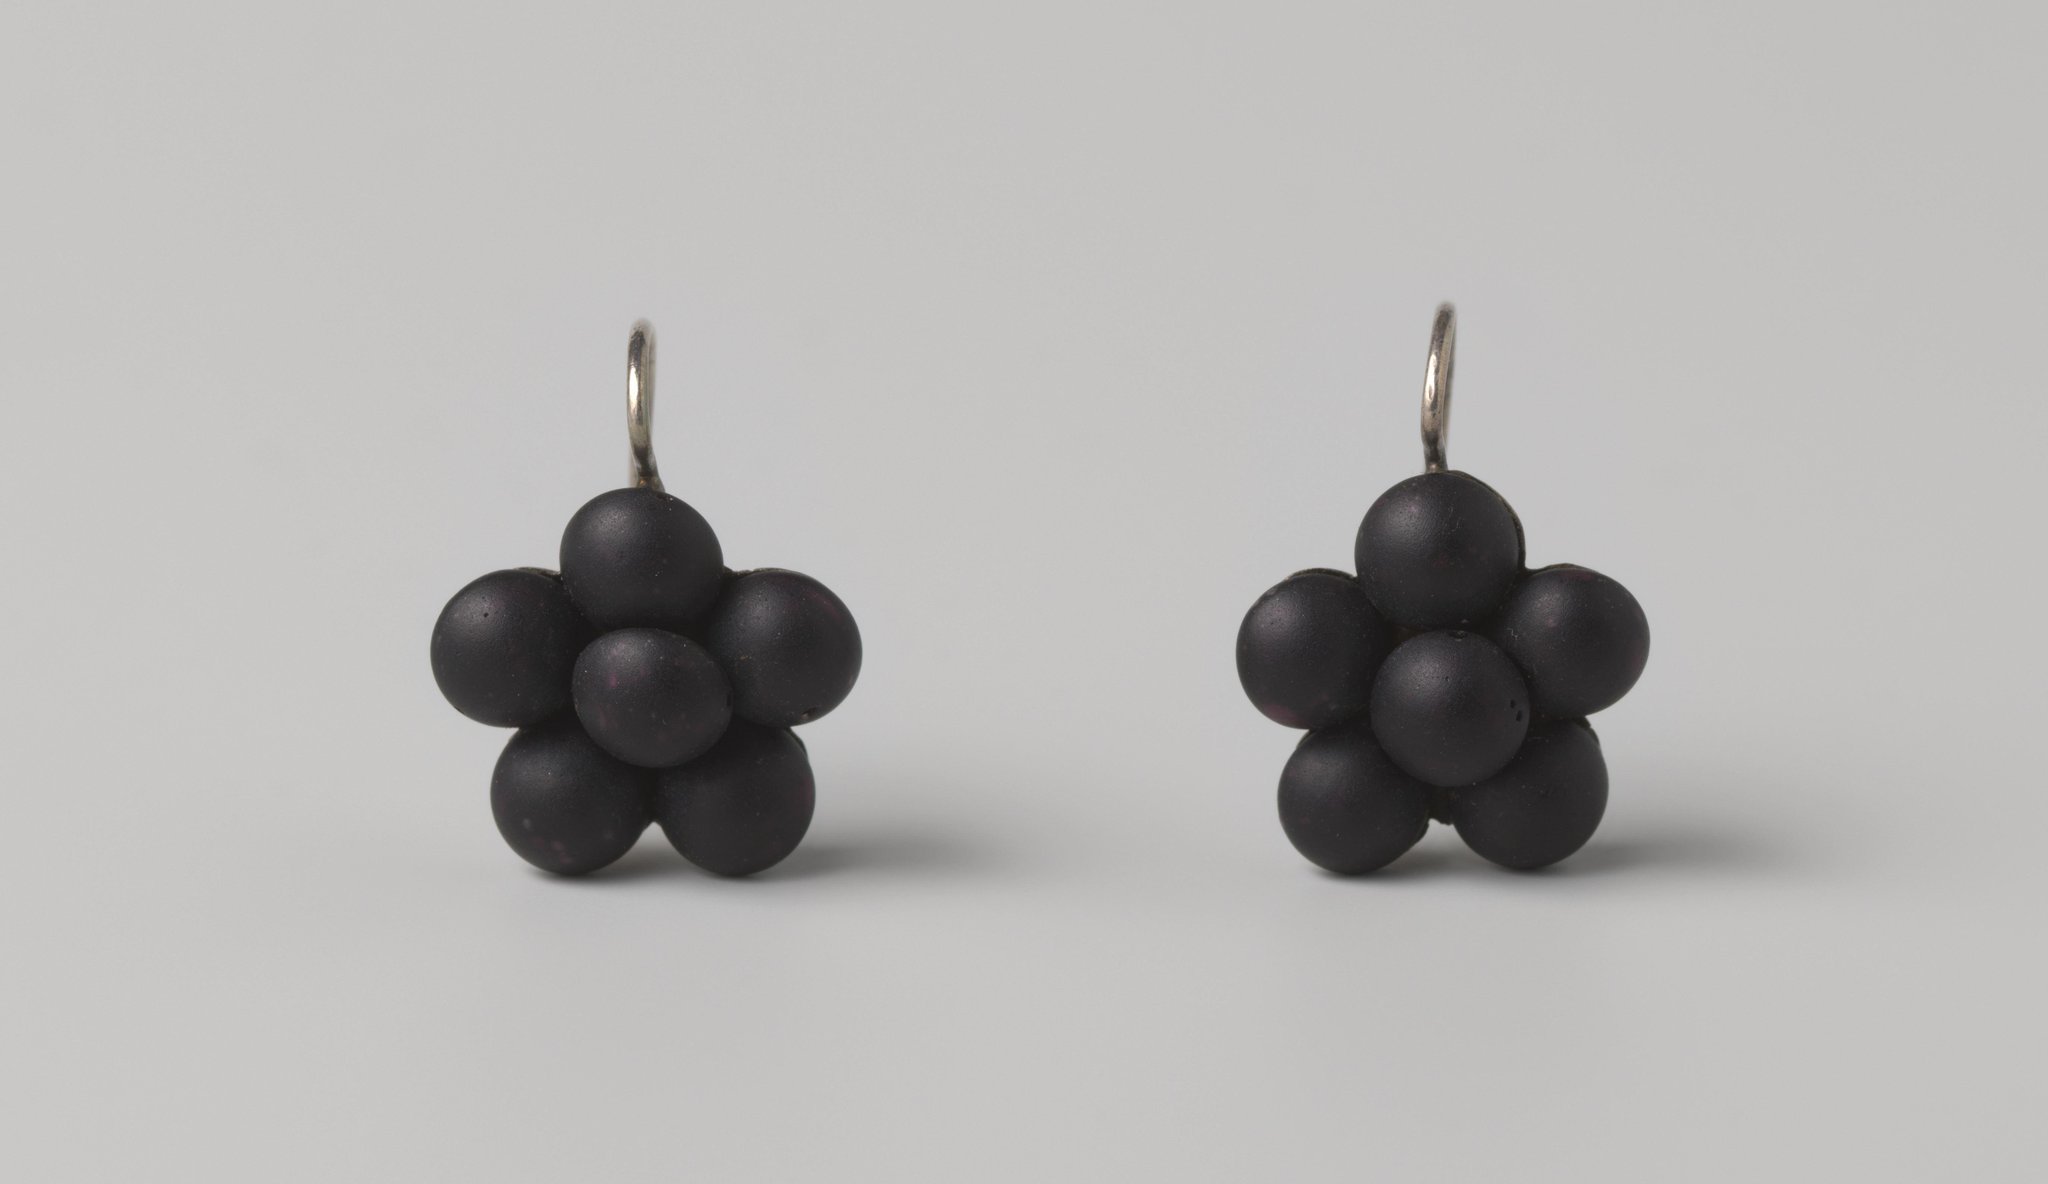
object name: mourning jewelry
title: Paar rouwoorbellen van halve bollen zwart glas op zilver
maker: Anonymous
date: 1880-1900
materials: glass, silver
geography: schoonhoven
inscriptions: alloy mark: ‘oud zwaard’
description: Paar rouwoorbellen van zwart glas en zilver. Elke oorbel bestaat uit zes halve bollen van zwart glas; vijf bollen zijn geschikt rond één centrale bol. Het glas is op zilver gezet.